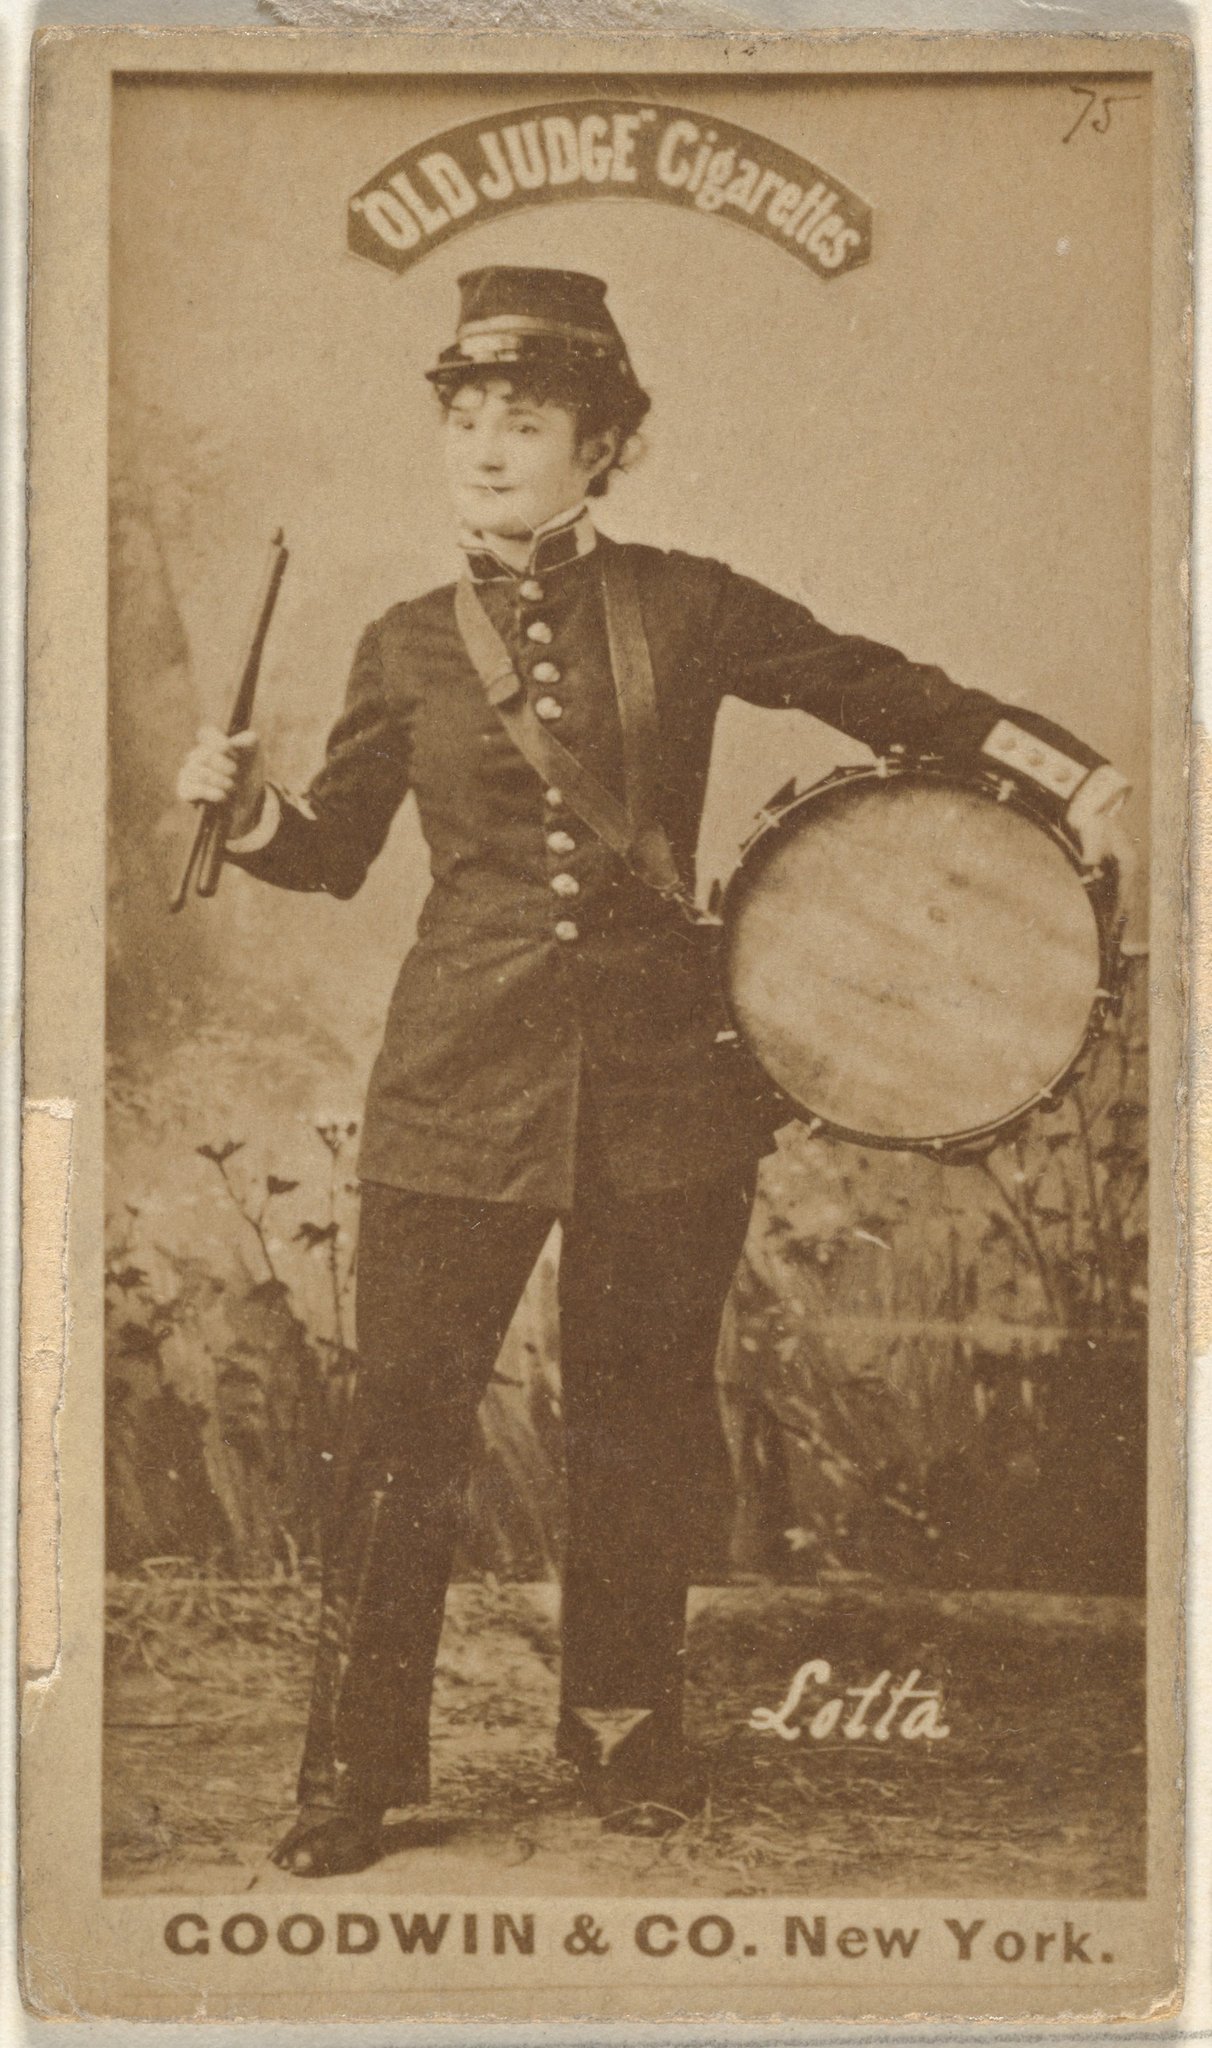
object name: photograph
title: Lotta, from the Actors and Actresses series (N171) for Old Judge Cigarettes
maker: goodwin & company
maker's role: publisher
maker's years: 1850-1950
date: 1886-1890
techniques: albumen silver print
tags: portraits,women,drums,actresses